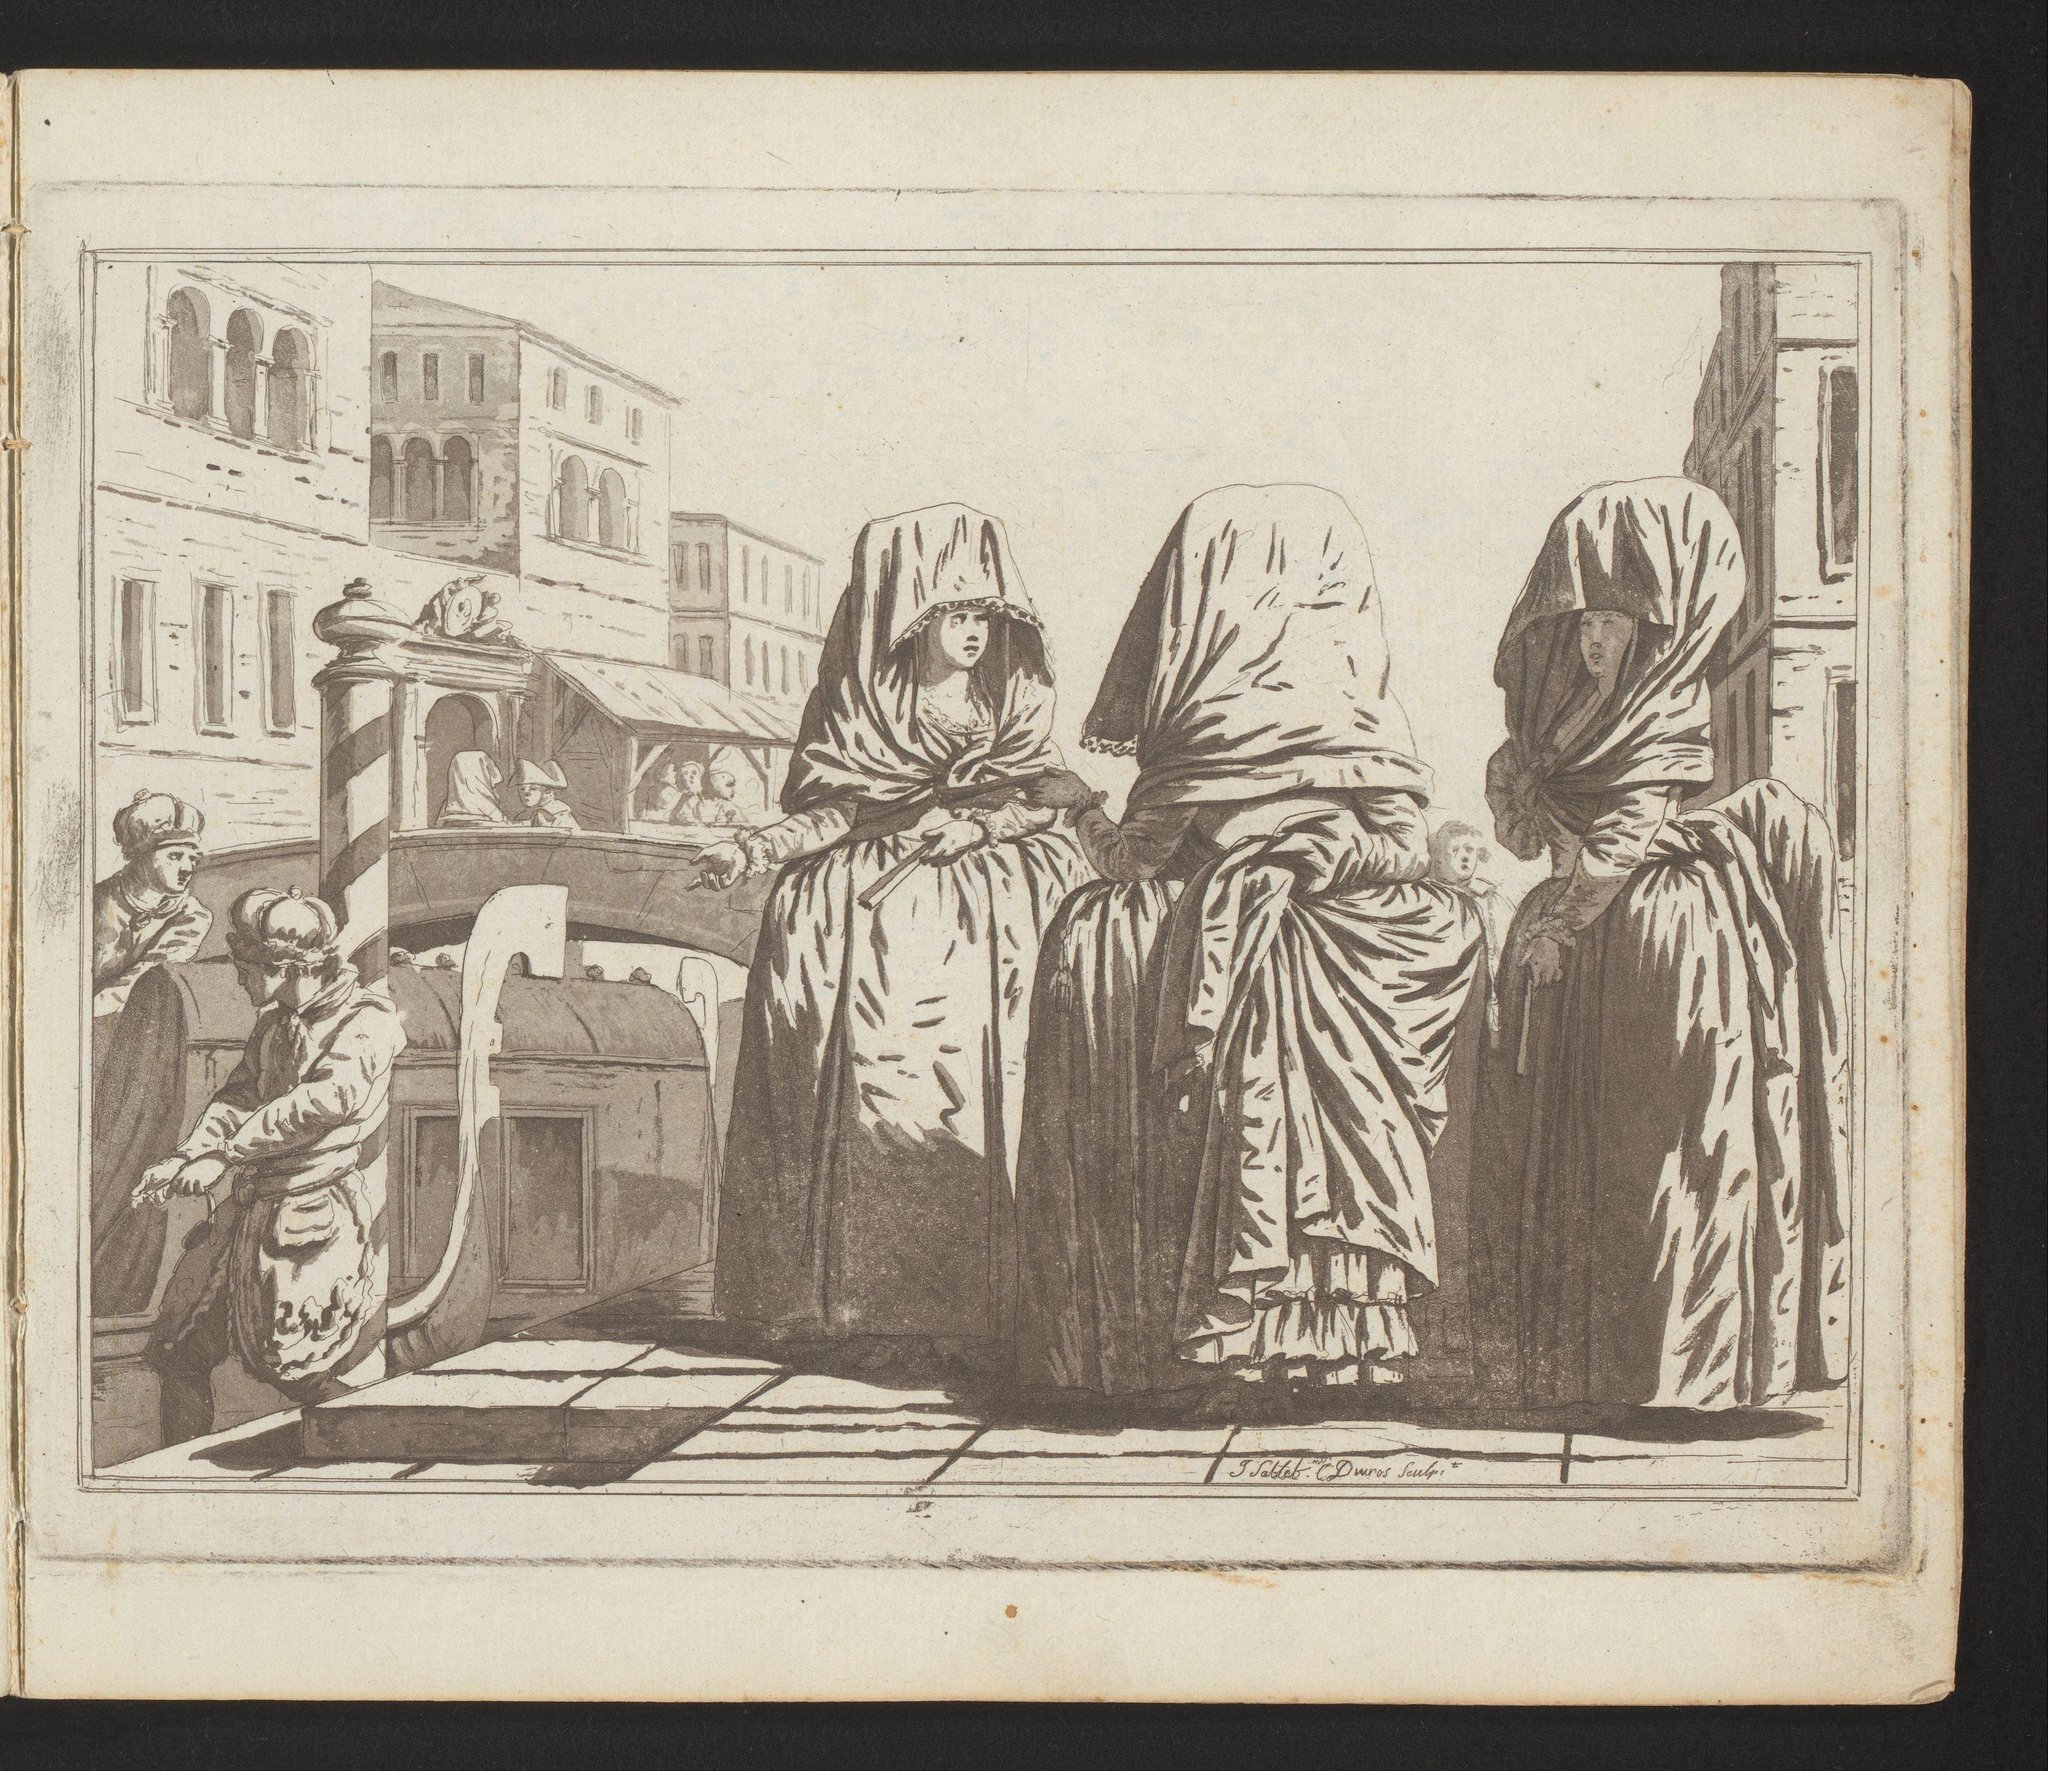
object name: album leaf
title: Drie dames in regionaal kostuum aan een gracht in Venetië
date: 1758-1810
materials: paper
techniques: aquatint, etching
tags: canals, waters (in city), dress, gown, gondola, europeans (with name), venice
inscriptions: collector's mark: Lugt 2228